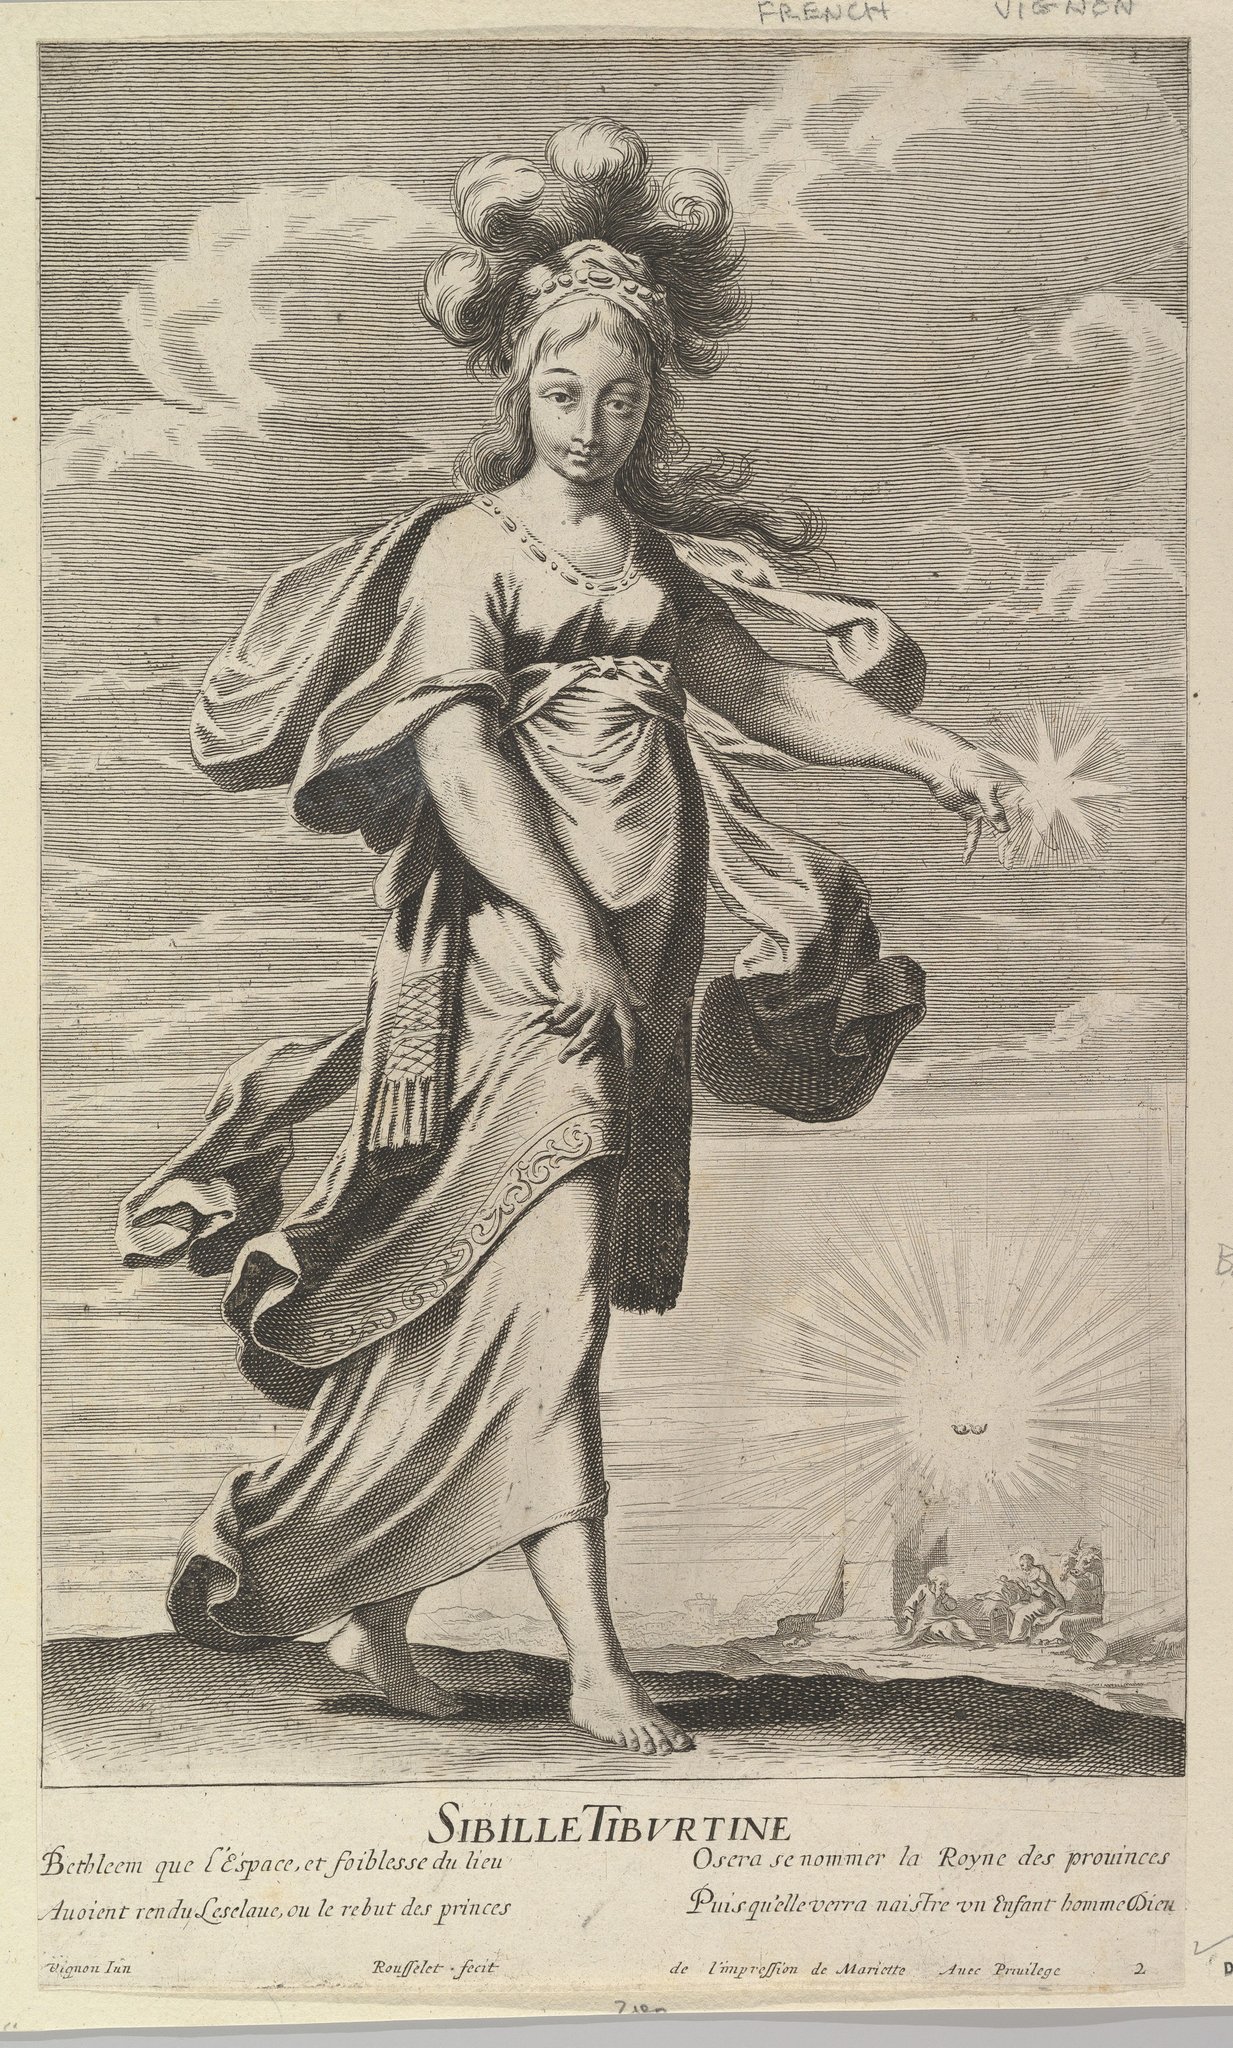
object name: print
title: Sibylle Tiburtine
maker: gilles rousselet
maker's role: artist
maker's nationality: french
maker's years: 1614-1686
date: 1635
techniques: engraving, etching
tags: portraits,women